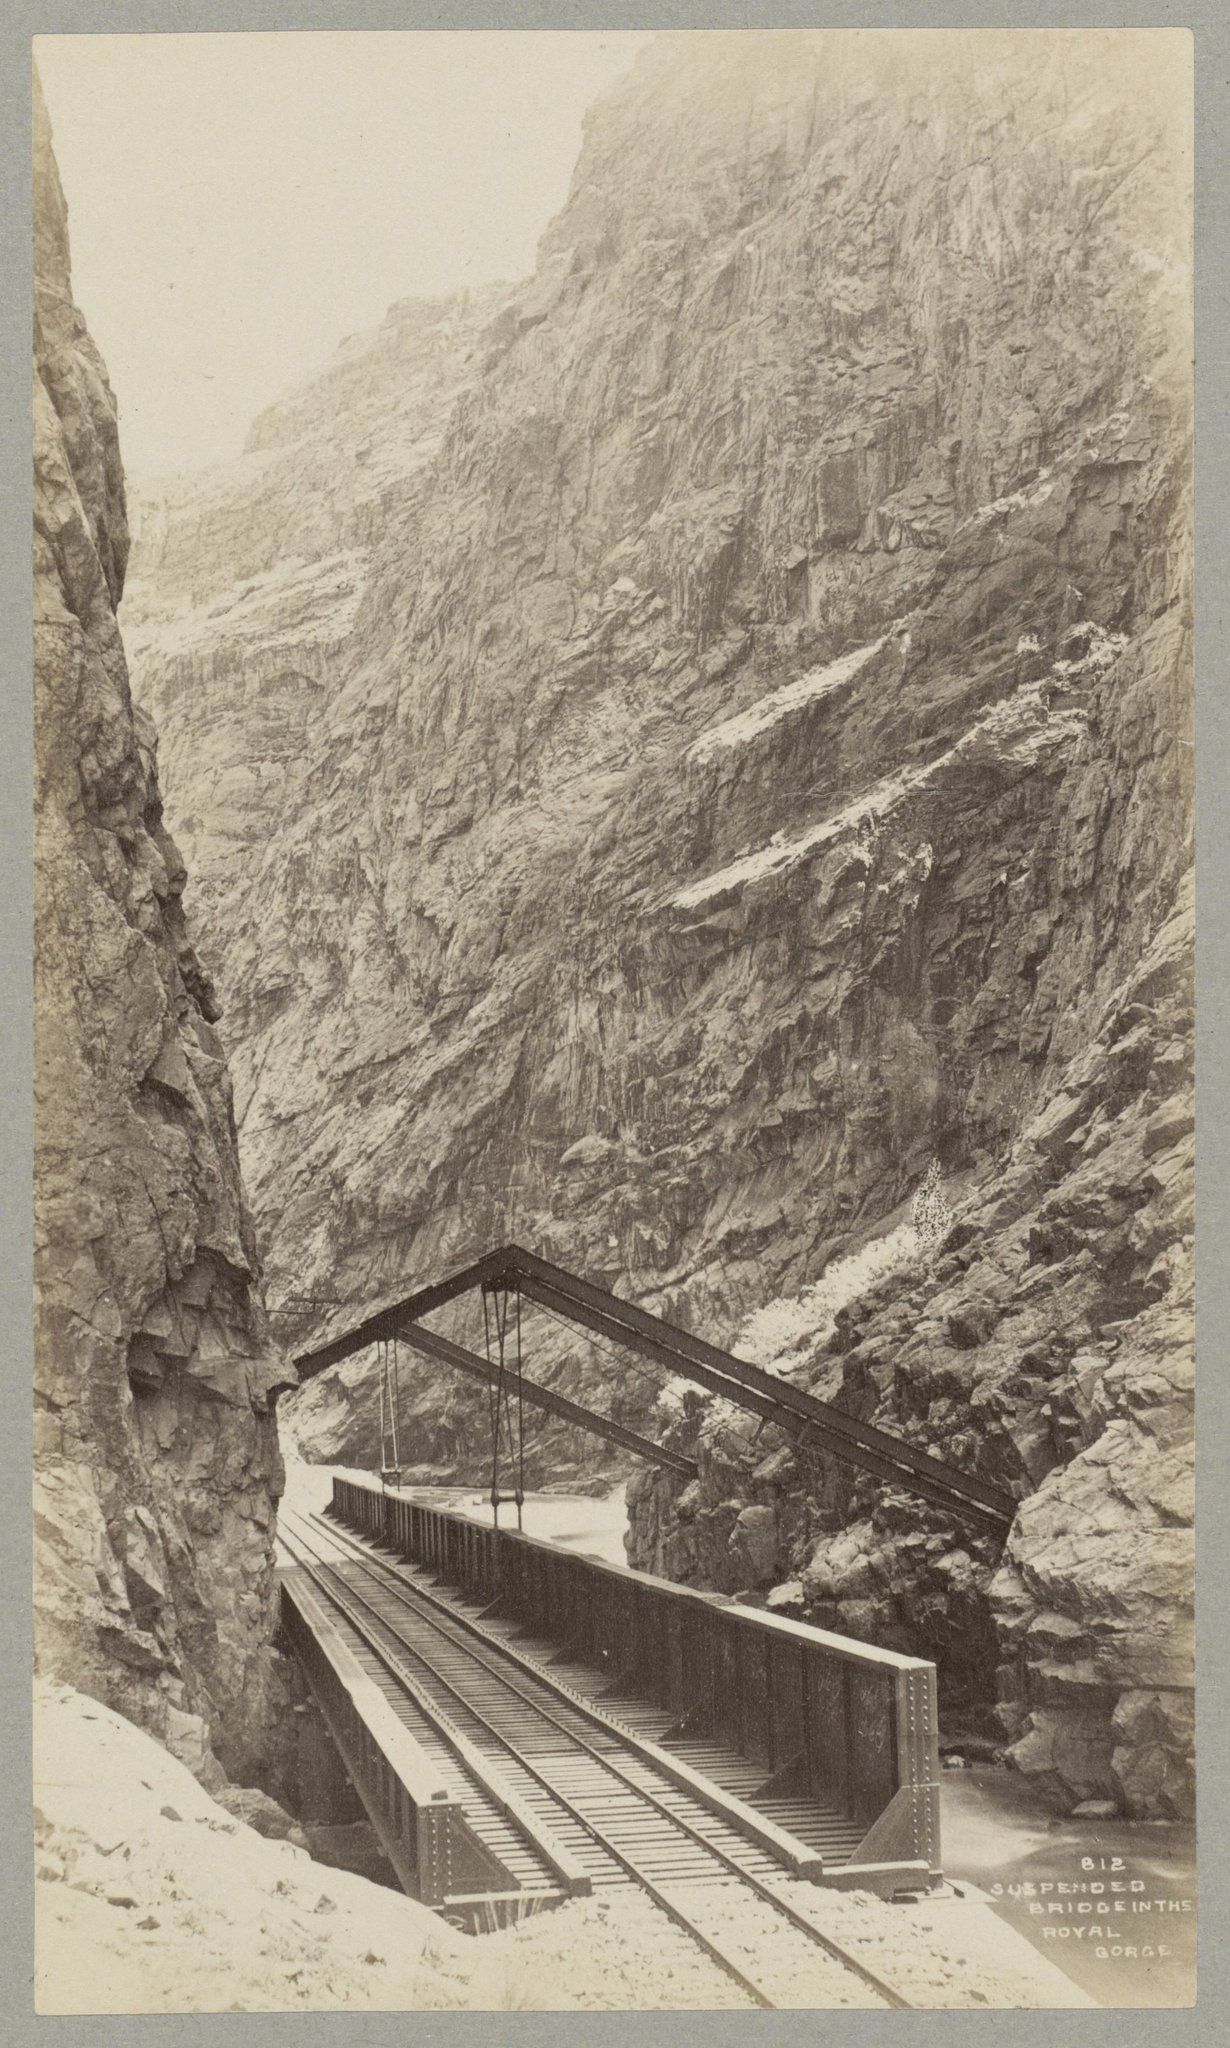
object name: photograph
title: Suspended Bridge in the Royal Gorge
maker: Anonymous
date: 1880-1900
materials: cardboard, paper, photographic support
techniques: albumen print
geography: cañon city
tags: ravine, chasm, abyss, canyon, railway, train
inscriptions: negative number: ‘812’